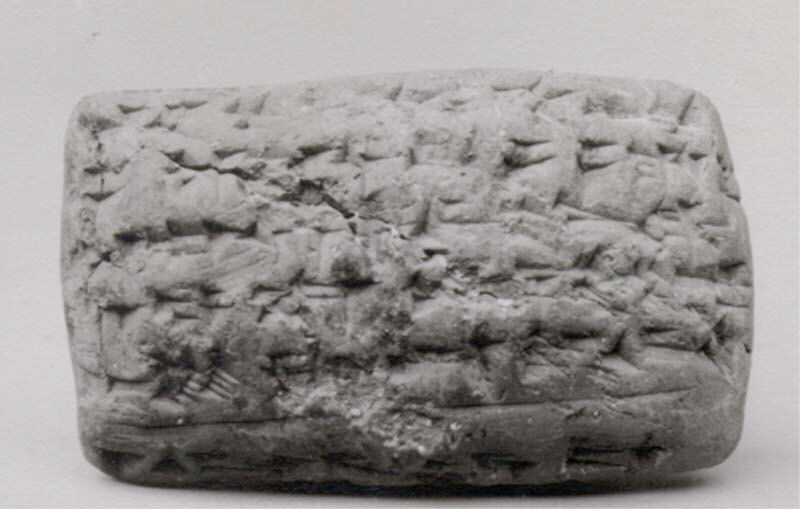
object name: cuneiform tablet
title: Cuneiform tablet: inventory account, Ebabbar archive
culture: babylonian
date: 700-501 BCE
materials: clay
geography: mesopotamia